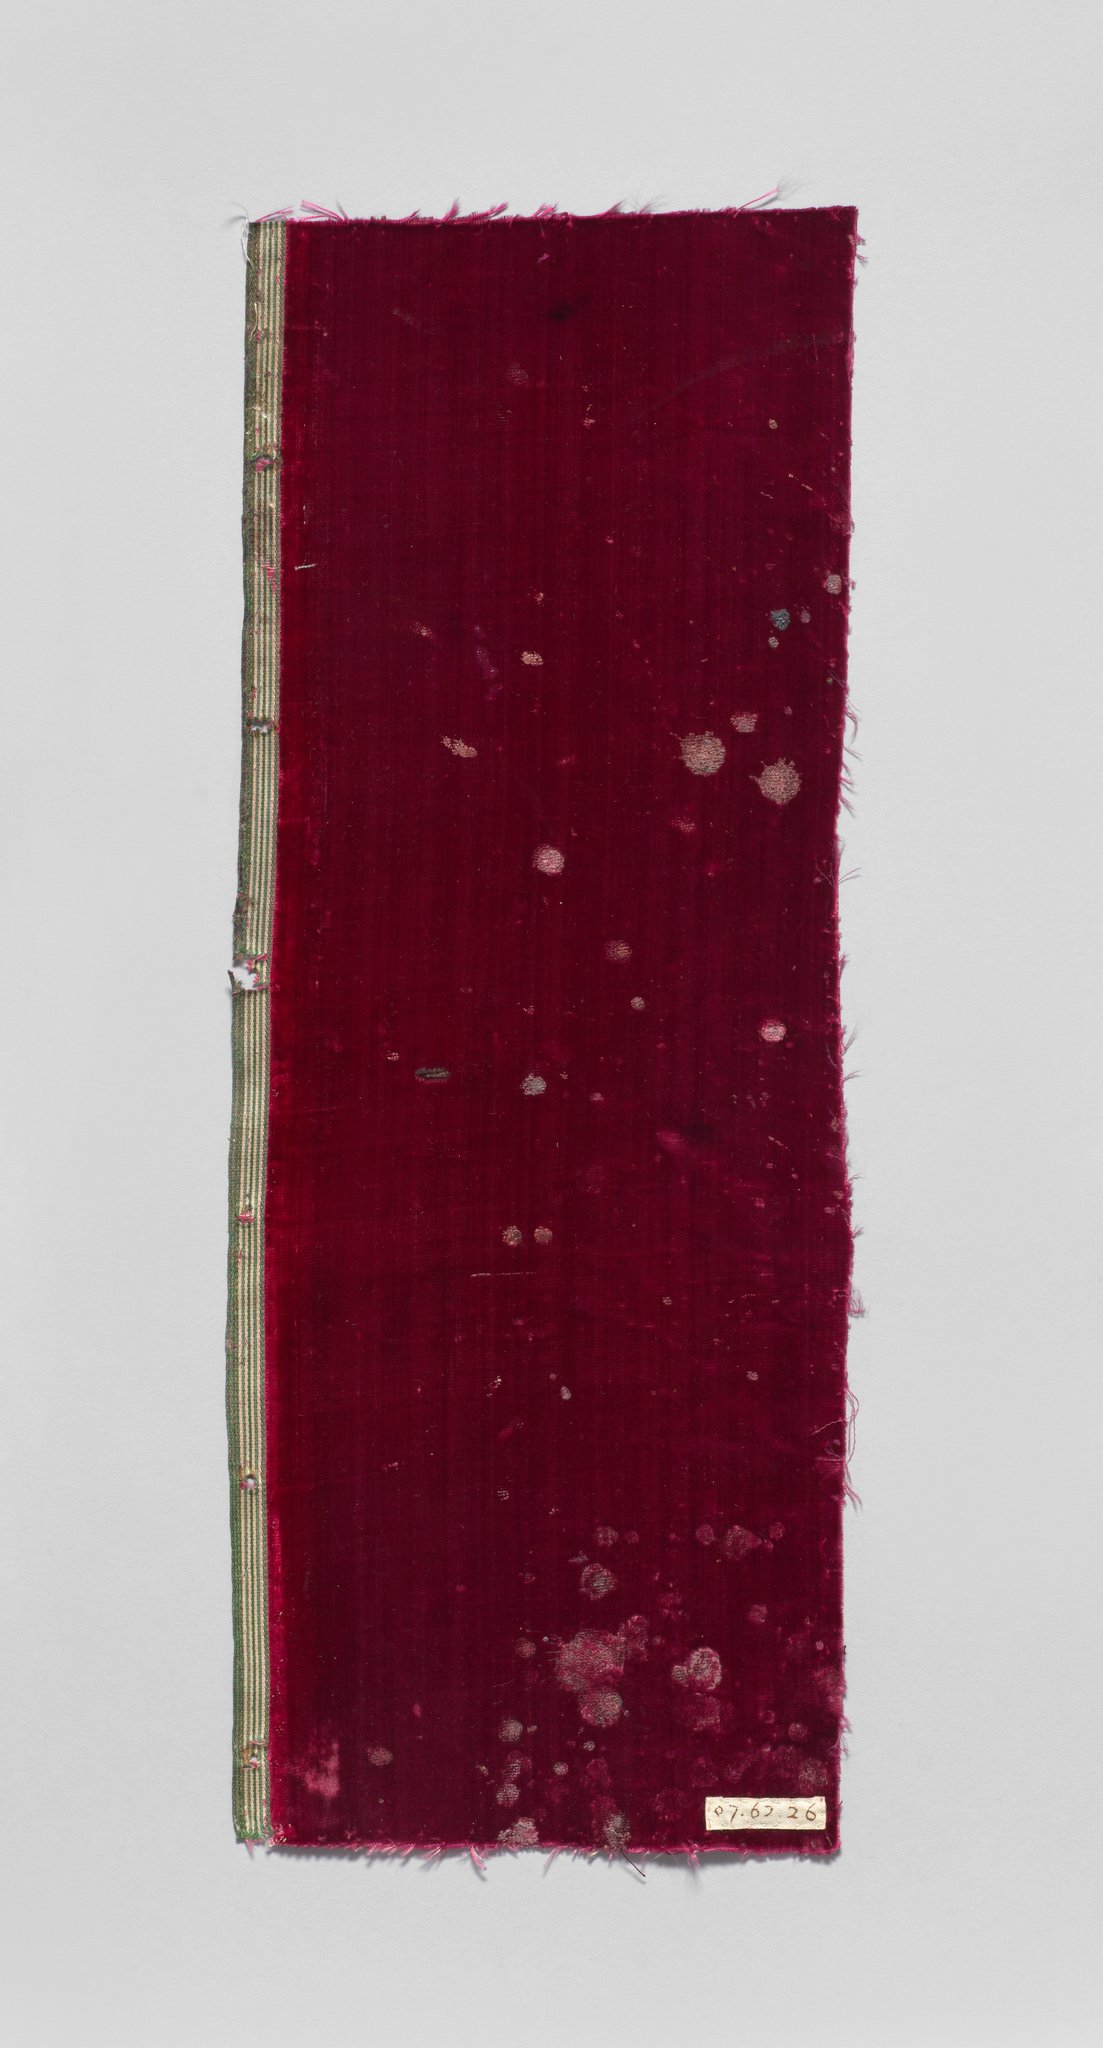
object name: piece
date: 1501-1600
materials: silk